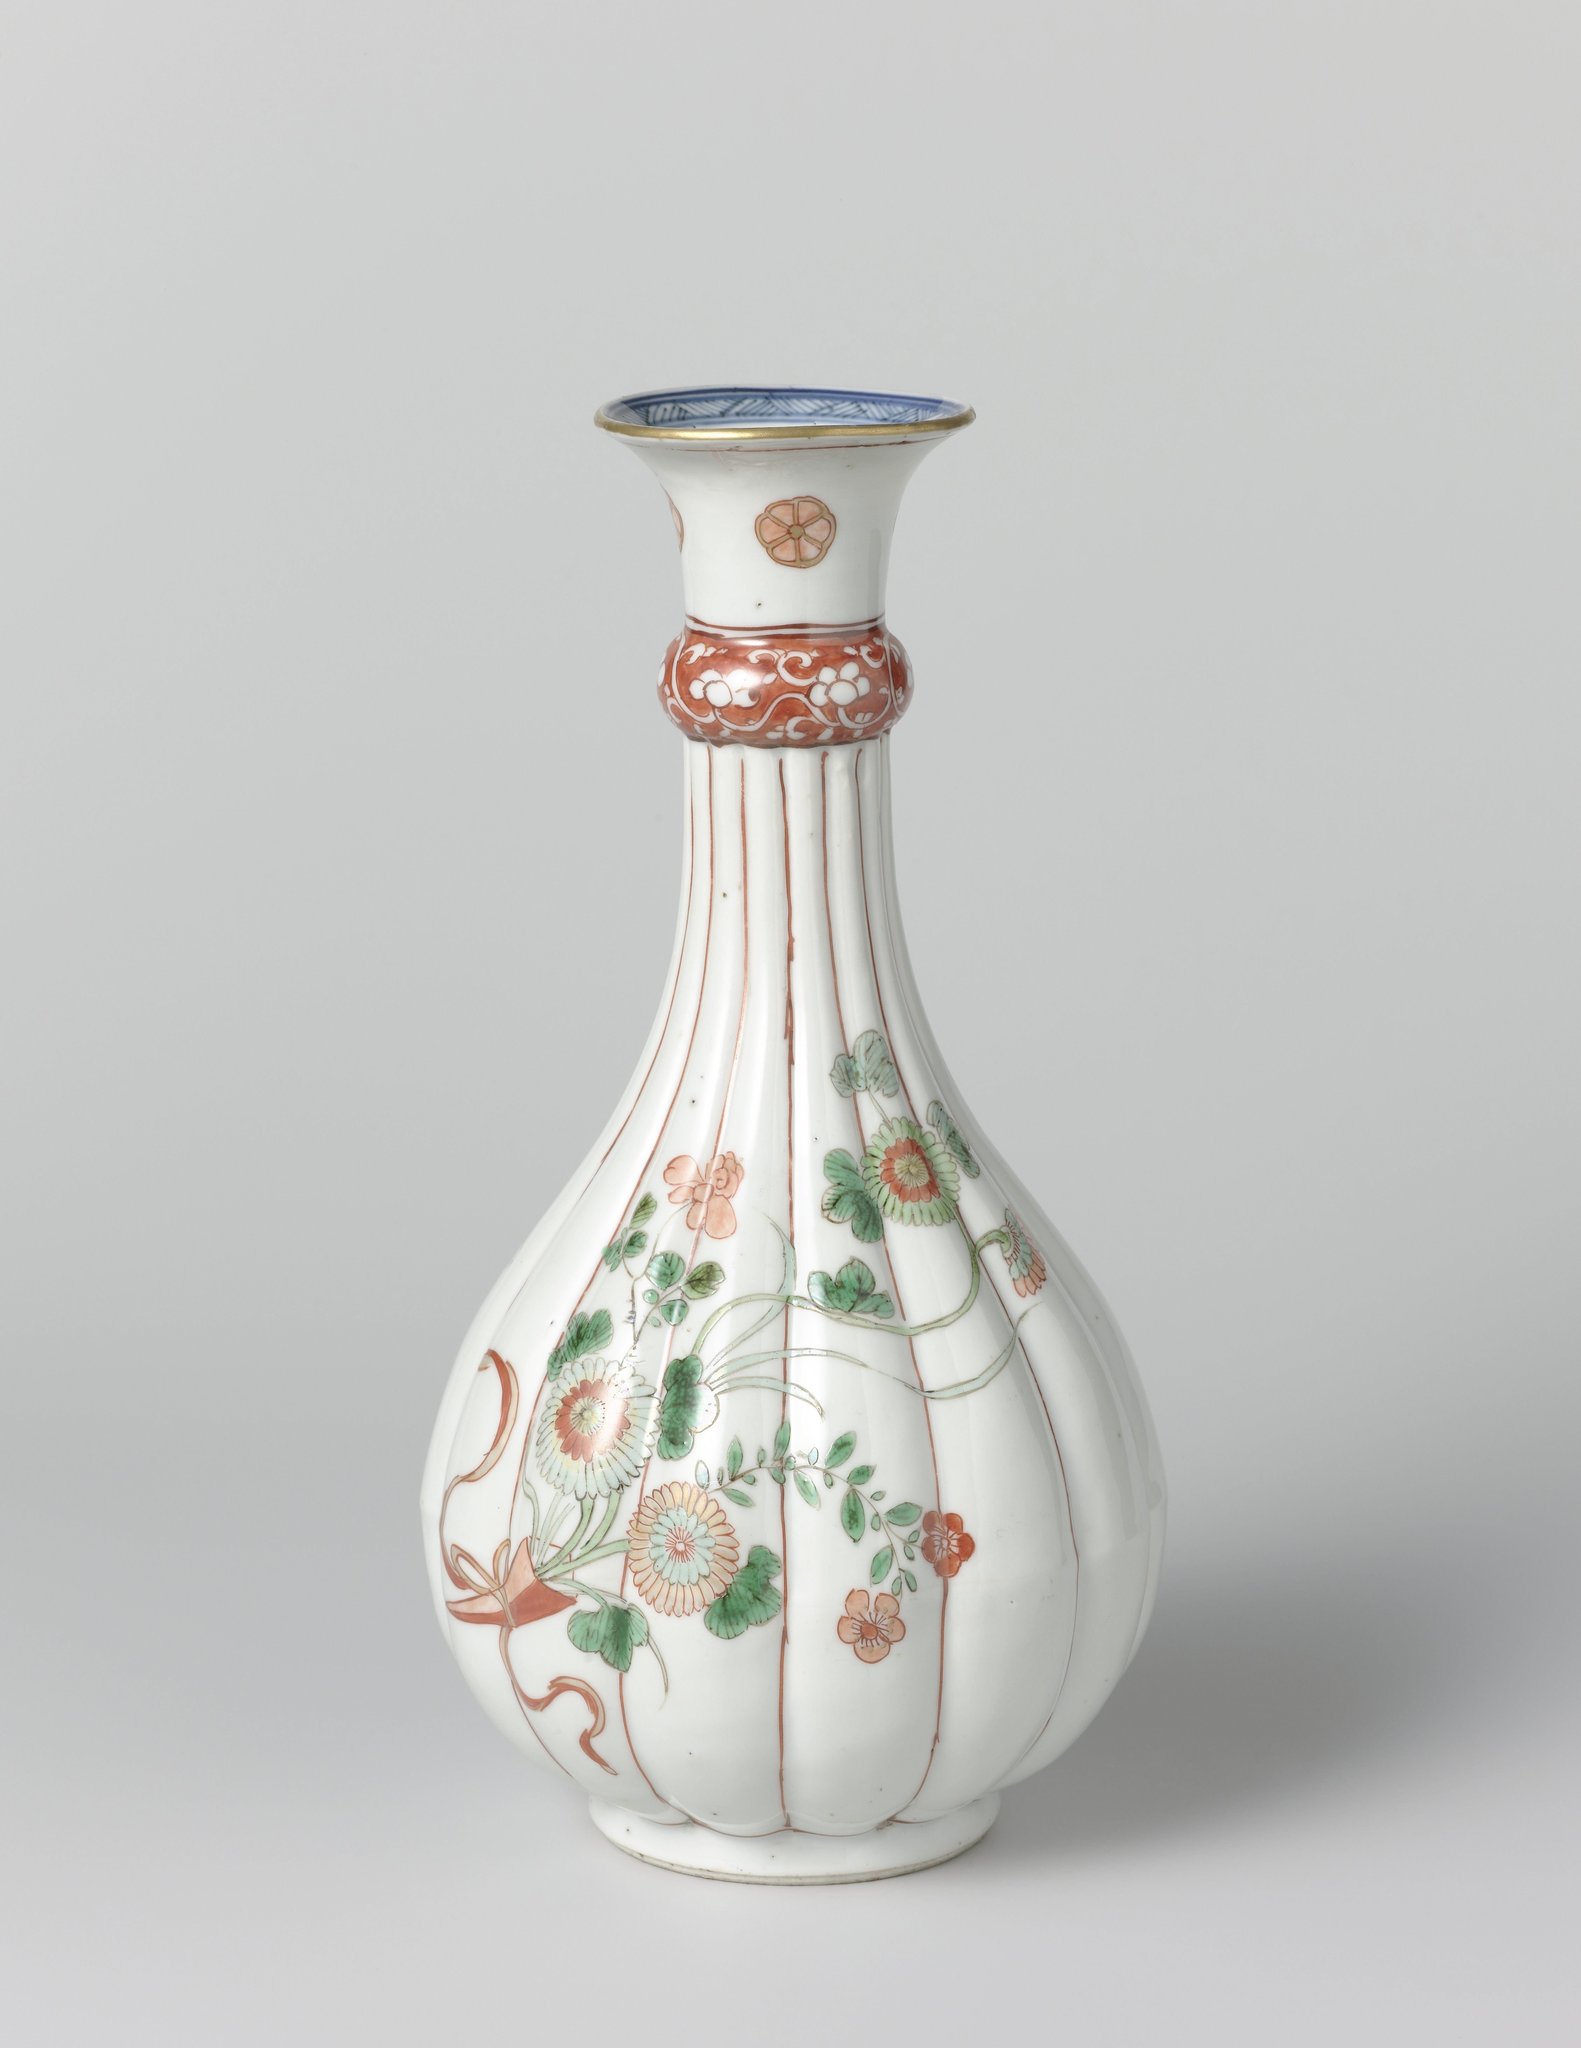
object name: vase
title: Pear-shaped, lobed vase with two bouquets and flower scrolls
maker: Anonymous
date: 1725-1735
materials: cobalt, glaze, gold, paint, porcelain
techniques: firing, forming, gilding, turning, vitrification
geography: china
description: AK-NM-6457 en 6443 Drie dekselpotten en twee flessen • Chinees Imari porselein, hier gerubriceerd bij het famille verte • Onderdeel van Royers porseleinverzameling • Gepubliceerd: Jörg 1997, nr. 200: Jörg 2011, nr. 159. Christiaan Jörg merkte op dat de geribde wand en de vorm van zowel pot als fles bekend zijn uit de Yongzheng-perioden (1722-1735). De schildering van de bloemtak is zonder twijfel in Japanse stijl. De stelen zijn gestoken in een papieren gevouwen bloemhouder – iets geheel Japans, en dat geldt ook voor de manier waarop de bloemen in de ruimte zijn geplaatst met een ruime witte achtergrond. De gedachte is wel dat Chinees Imari aanvankelijk sterk op de Japanse voorbeelden leek en daarna een meer Chinees uiterlijk kreeg door de manier waarop de motieven zijn geschilderd. Dit kaststel toont aan dat het niet zo eenduidig is. Dit is vrij laat voor Chinees Imari, maar als de schilders daarvoor kozen konden zij dus nog steeds in Japanse stijl werken. Dit is een fraai kaststel, maar het is niet zeer zeldzaam Intussen zijn in een flink aantal collecties tenminste identieke delen teruggevonden [zie de verwijzingen bij jörg, onder meer naar een dekselpot in de Chinees keizerlijke collectie]. Ze zijn altijd precies gelijk aan deze set van Royer – vergelijkbare maar net anders uitgevoerde stukken ontbreken. Dat duidt erop dat waarschijnlijk één keer een flinke partij vervaardigd is, maar dat de productie niet werd voortgezet. Verschillende van de identieke stukken in andere collecties hebben een vorstelijke of adellijke provenance: de Medici-collectie [Morena 2005, nr. 135], Prince Marc de Beauvau Craon [Sotheby’s Parijs, 15 sept 2017, nr. 22]; Maria Beatrice di Savoia (principessa reale) [aangeboden door Van der Ven in 2006]. Ik zie hierin een aanwijzing dat deze stukken tot het meest luxueuze porselein van het moment gerekend kunnen worden. Het is interessant dat Royer – helaas weten we niet op welke manier – een dergelijke exclusieve set in zijn bezit kreeg. Bronnen: Christiaan J.A. Jörg, Chinese ceramics in the collection of the Rijksmuseum, Amsterdam: the Ming and Qing dynasties, Londen, 1997. F. Morena, Dalle Indie orientali alla corte di Toscana. Collezione di arte cinese e giapponese a Palazzo Pitti, Florence, 2005. Christiaan J.A. Jörg, Famille verte: Chinese porcelain in green enamels, Groningen, 2011.